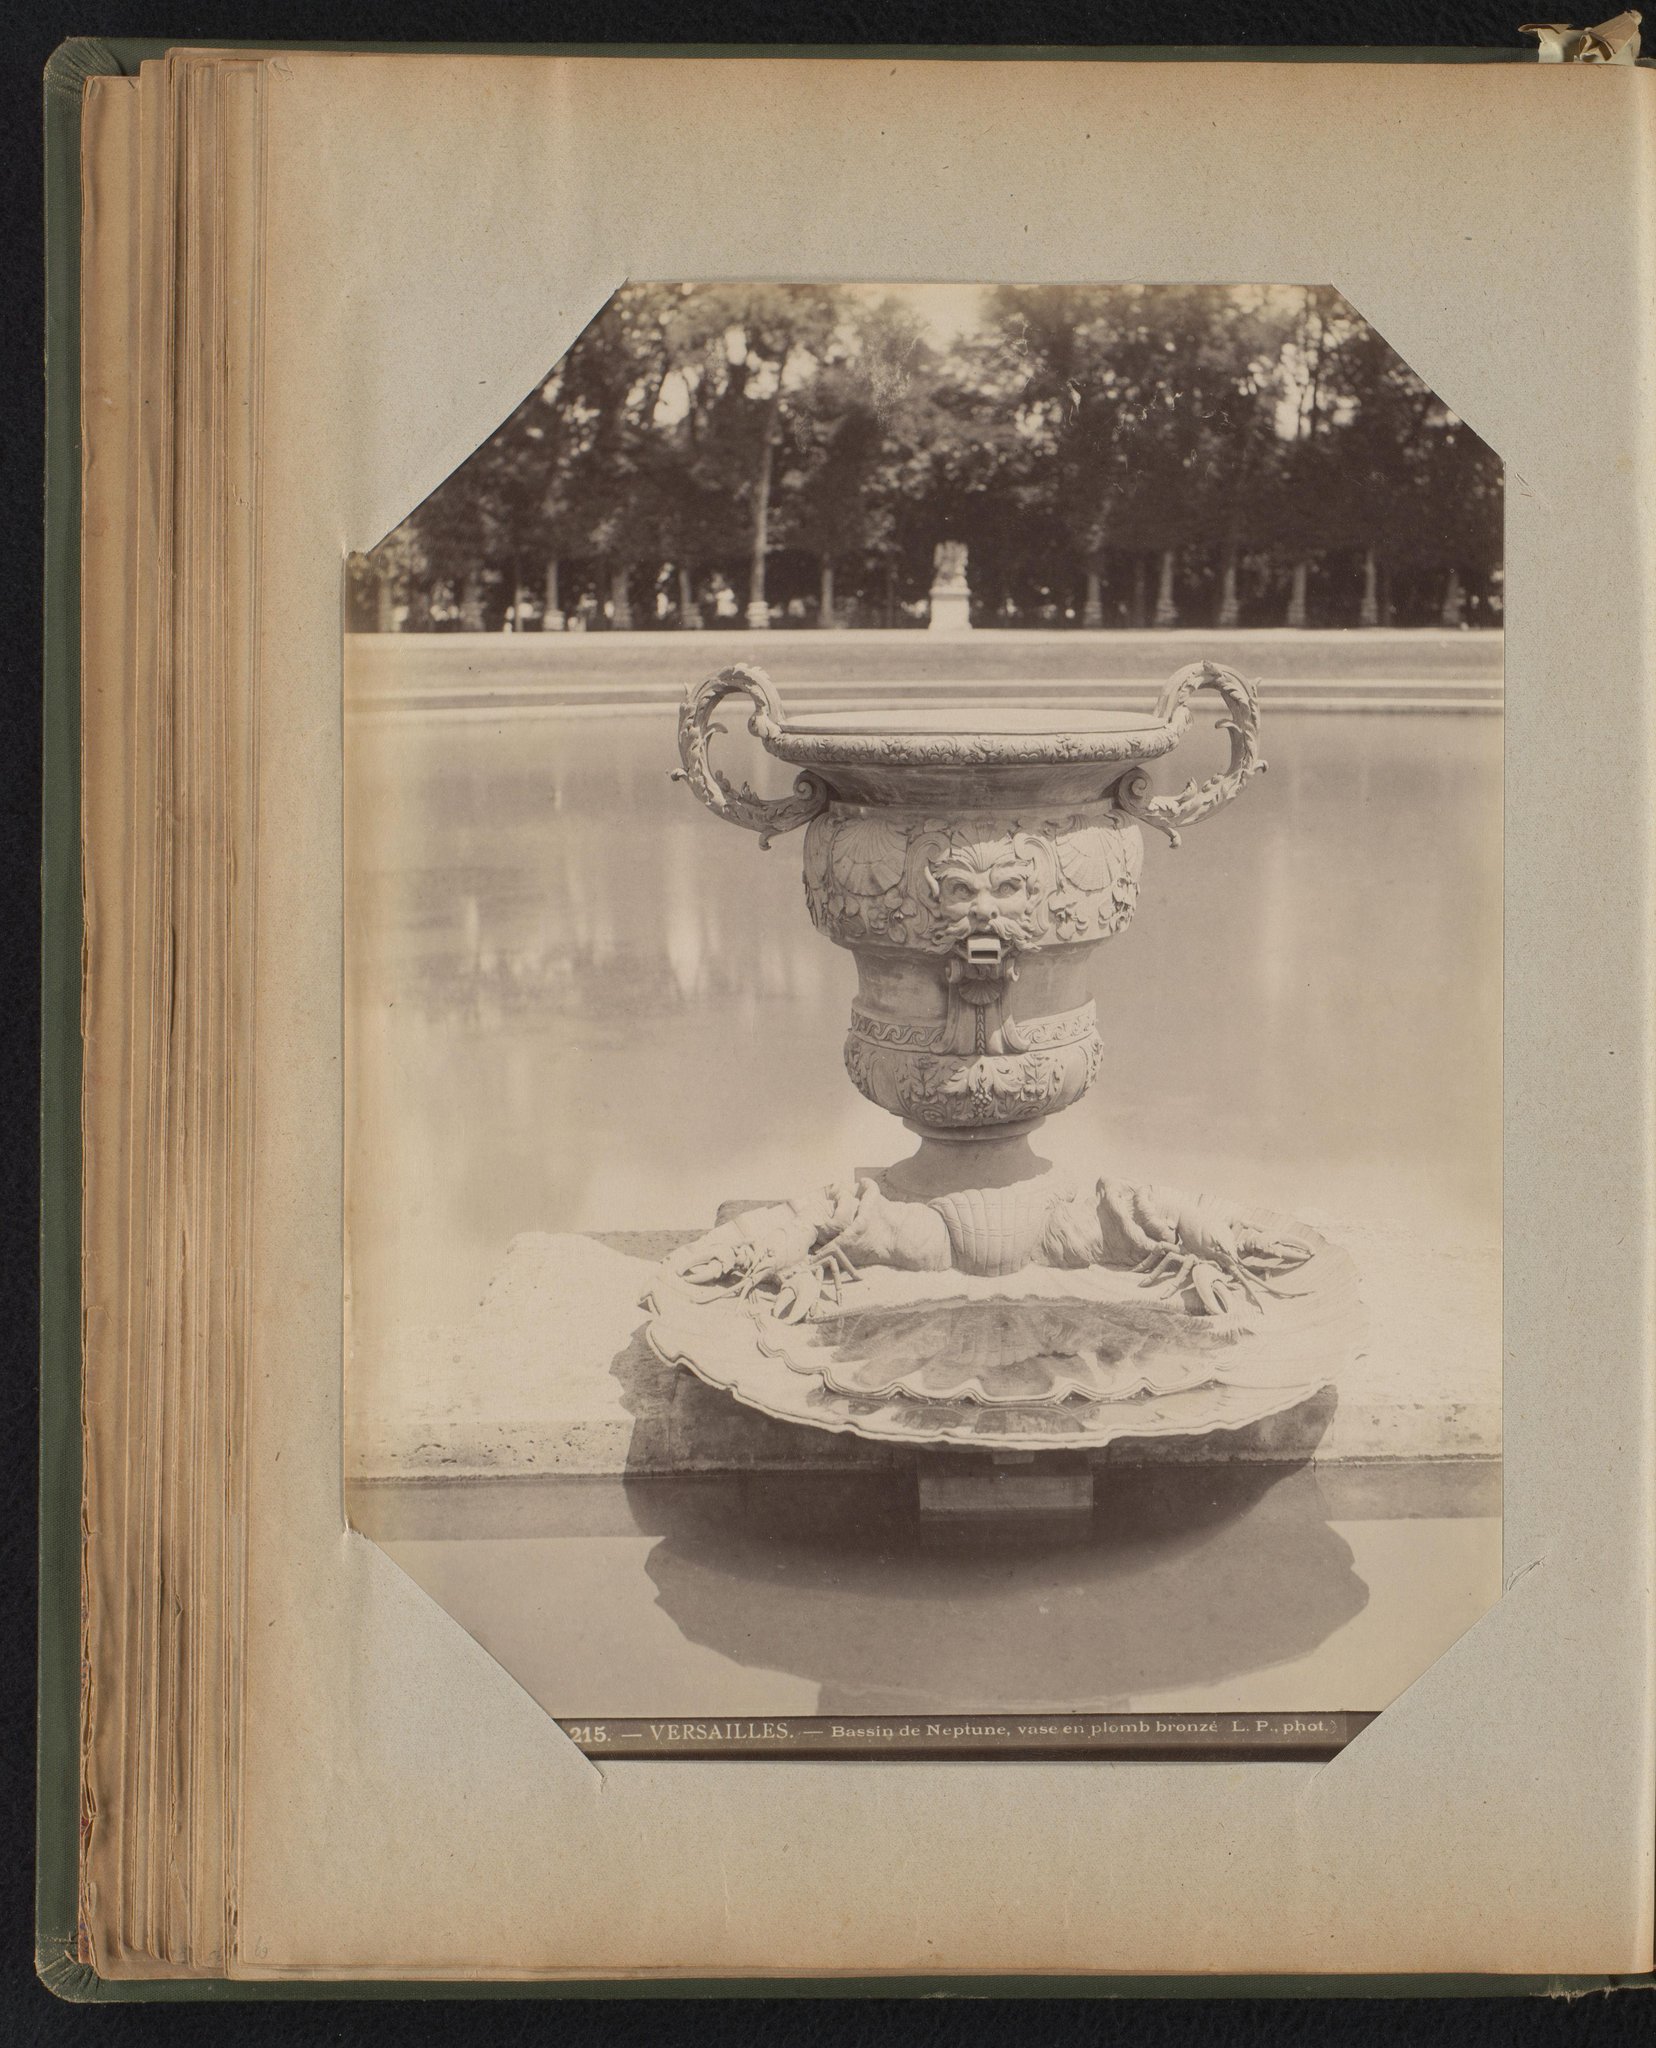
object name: photograph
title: Bronzen vaas met daarin verwerkt waterspuwers aan de rand van een bassin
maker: Anonymous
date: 1860-1900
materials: paper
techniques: albumen print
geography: france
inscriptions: annotation: ‘215 - Versailles - Bassin de Neptune, vase en plomp bronze L.P. Phot.’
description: De vaas is gedecoreerd met kreeften en zeedieren. Onderdeel van een serie met betrekking tot het interieur van het paleis van Versailles met kroonluchters, deuren, portalen en meubelstukken.